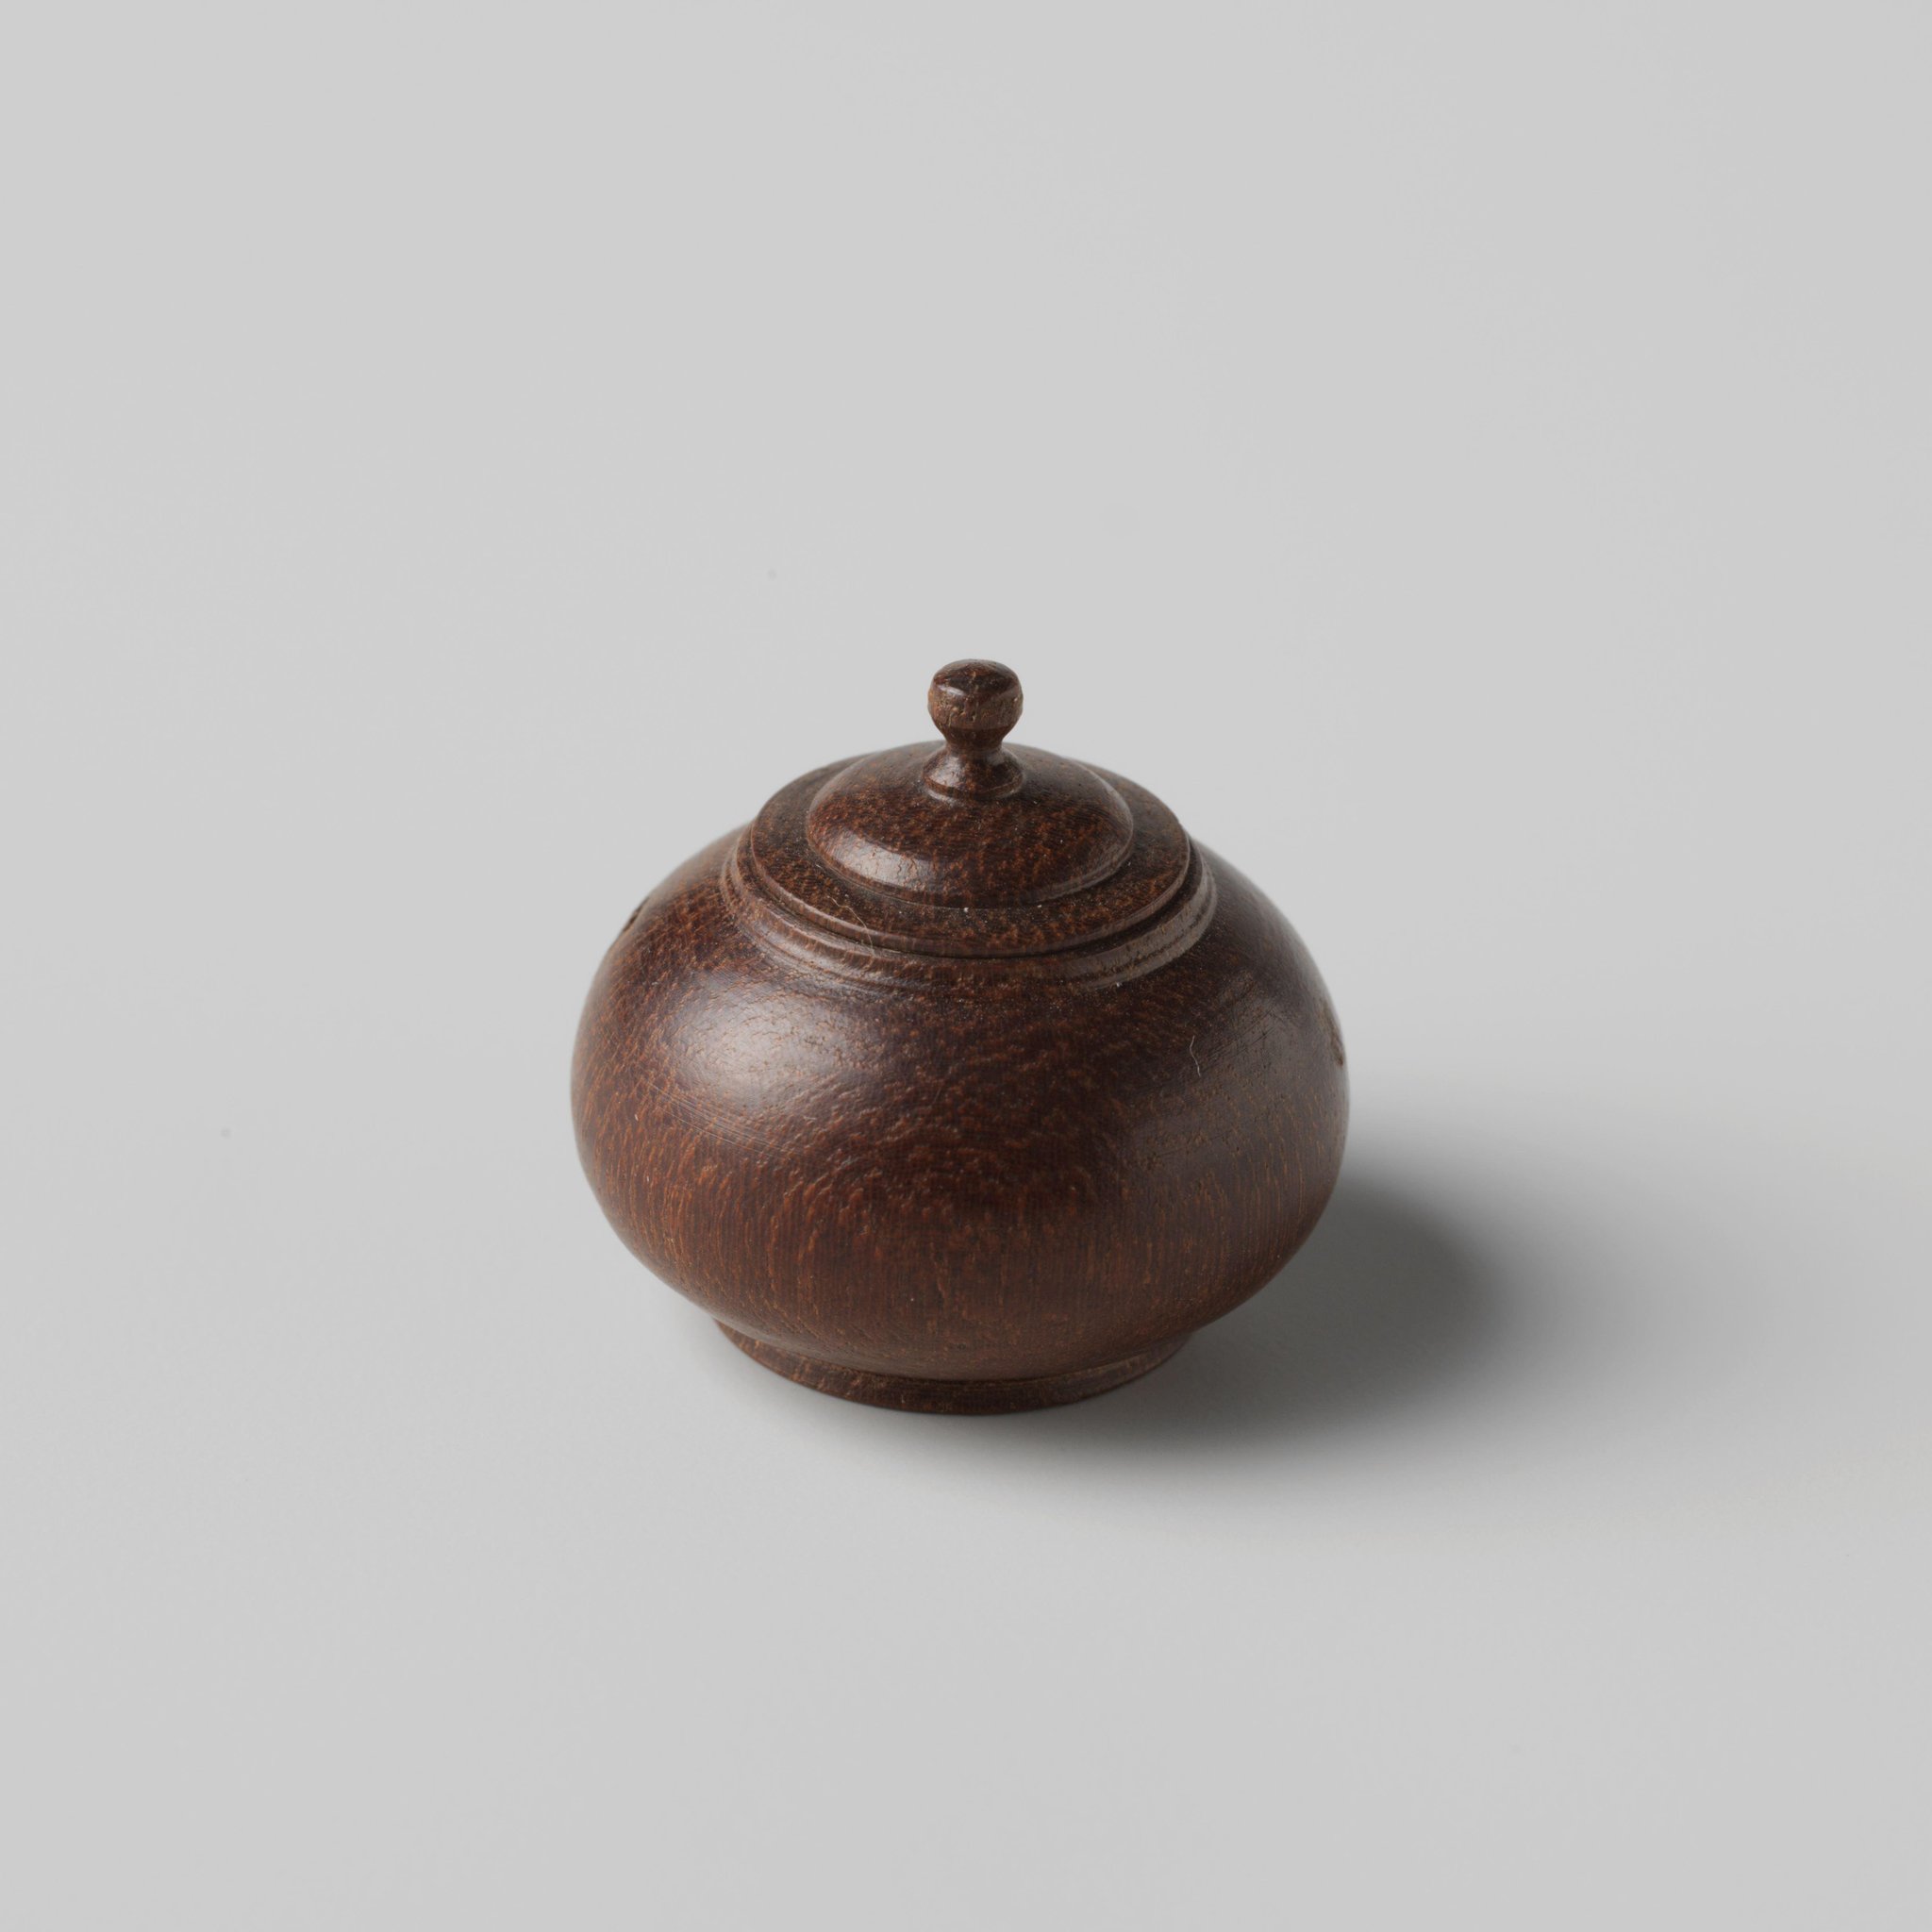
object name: teapot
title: Theepot met deksel van gedraaid hout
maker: Anonymous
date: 1800-1899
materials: wood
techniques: tropisch hardhout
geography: england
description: Theepot gedraaid van donkere hardhoutsoort zonder oor, met gat voor tuit en losse deksel.